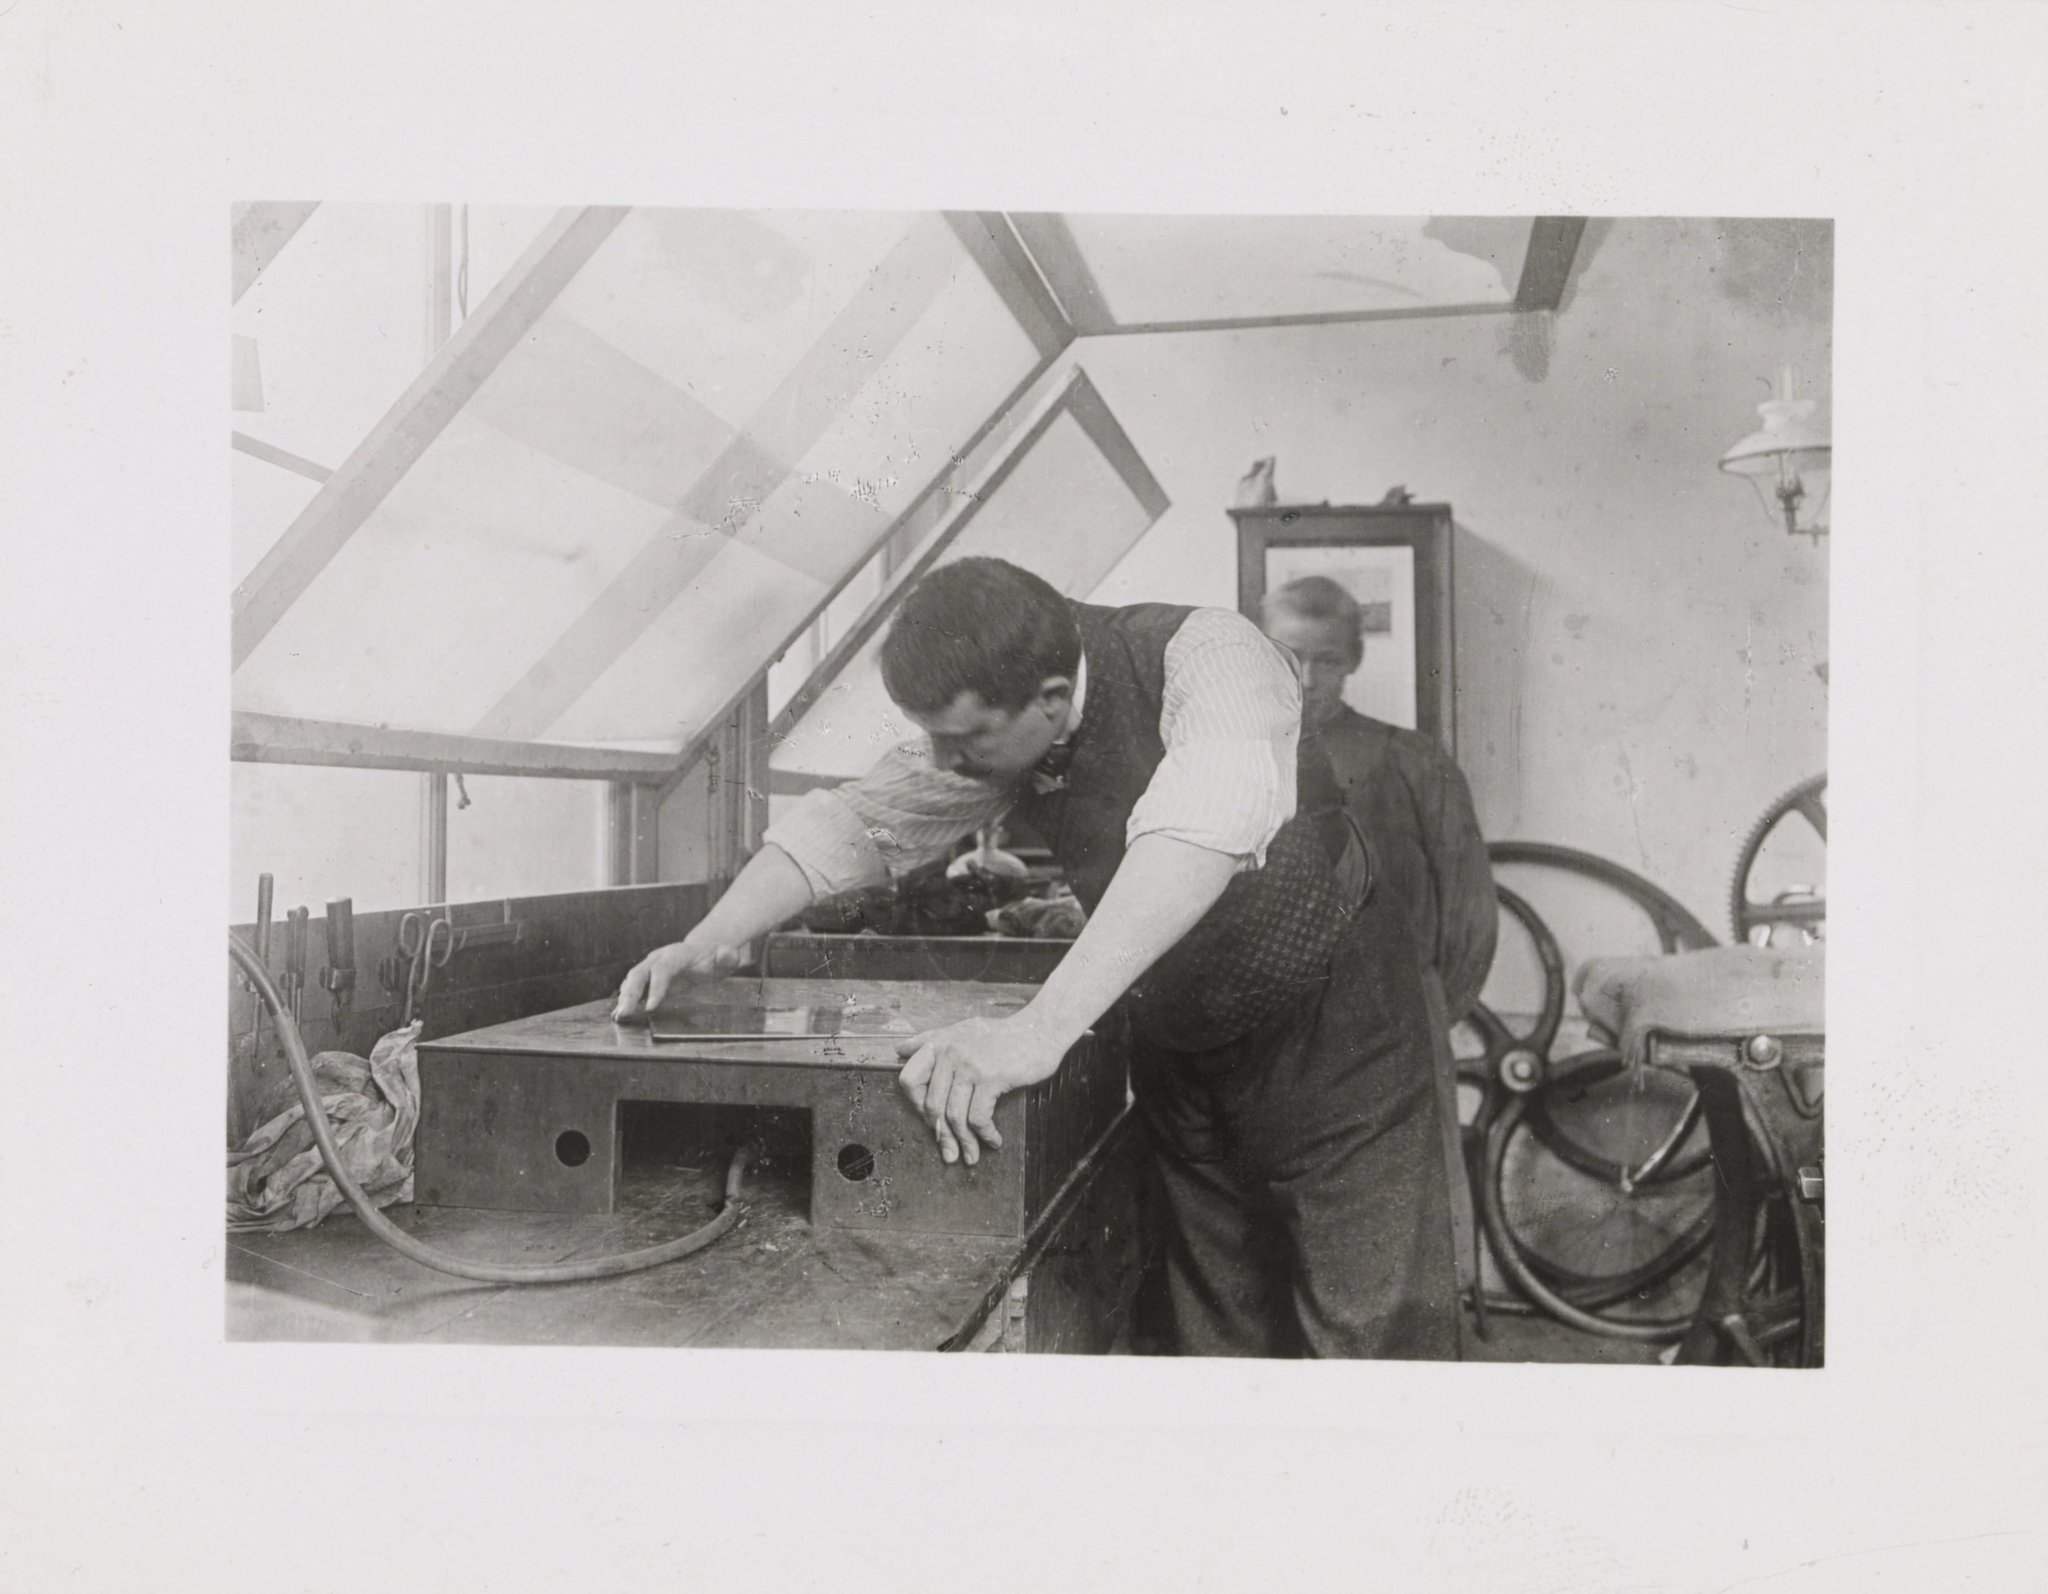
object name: photograph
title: Reproductie naar een foto, schilderij, tekening of prent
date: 1860-1915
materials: paper, photographic support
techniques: gelatin silver print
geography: netherlands